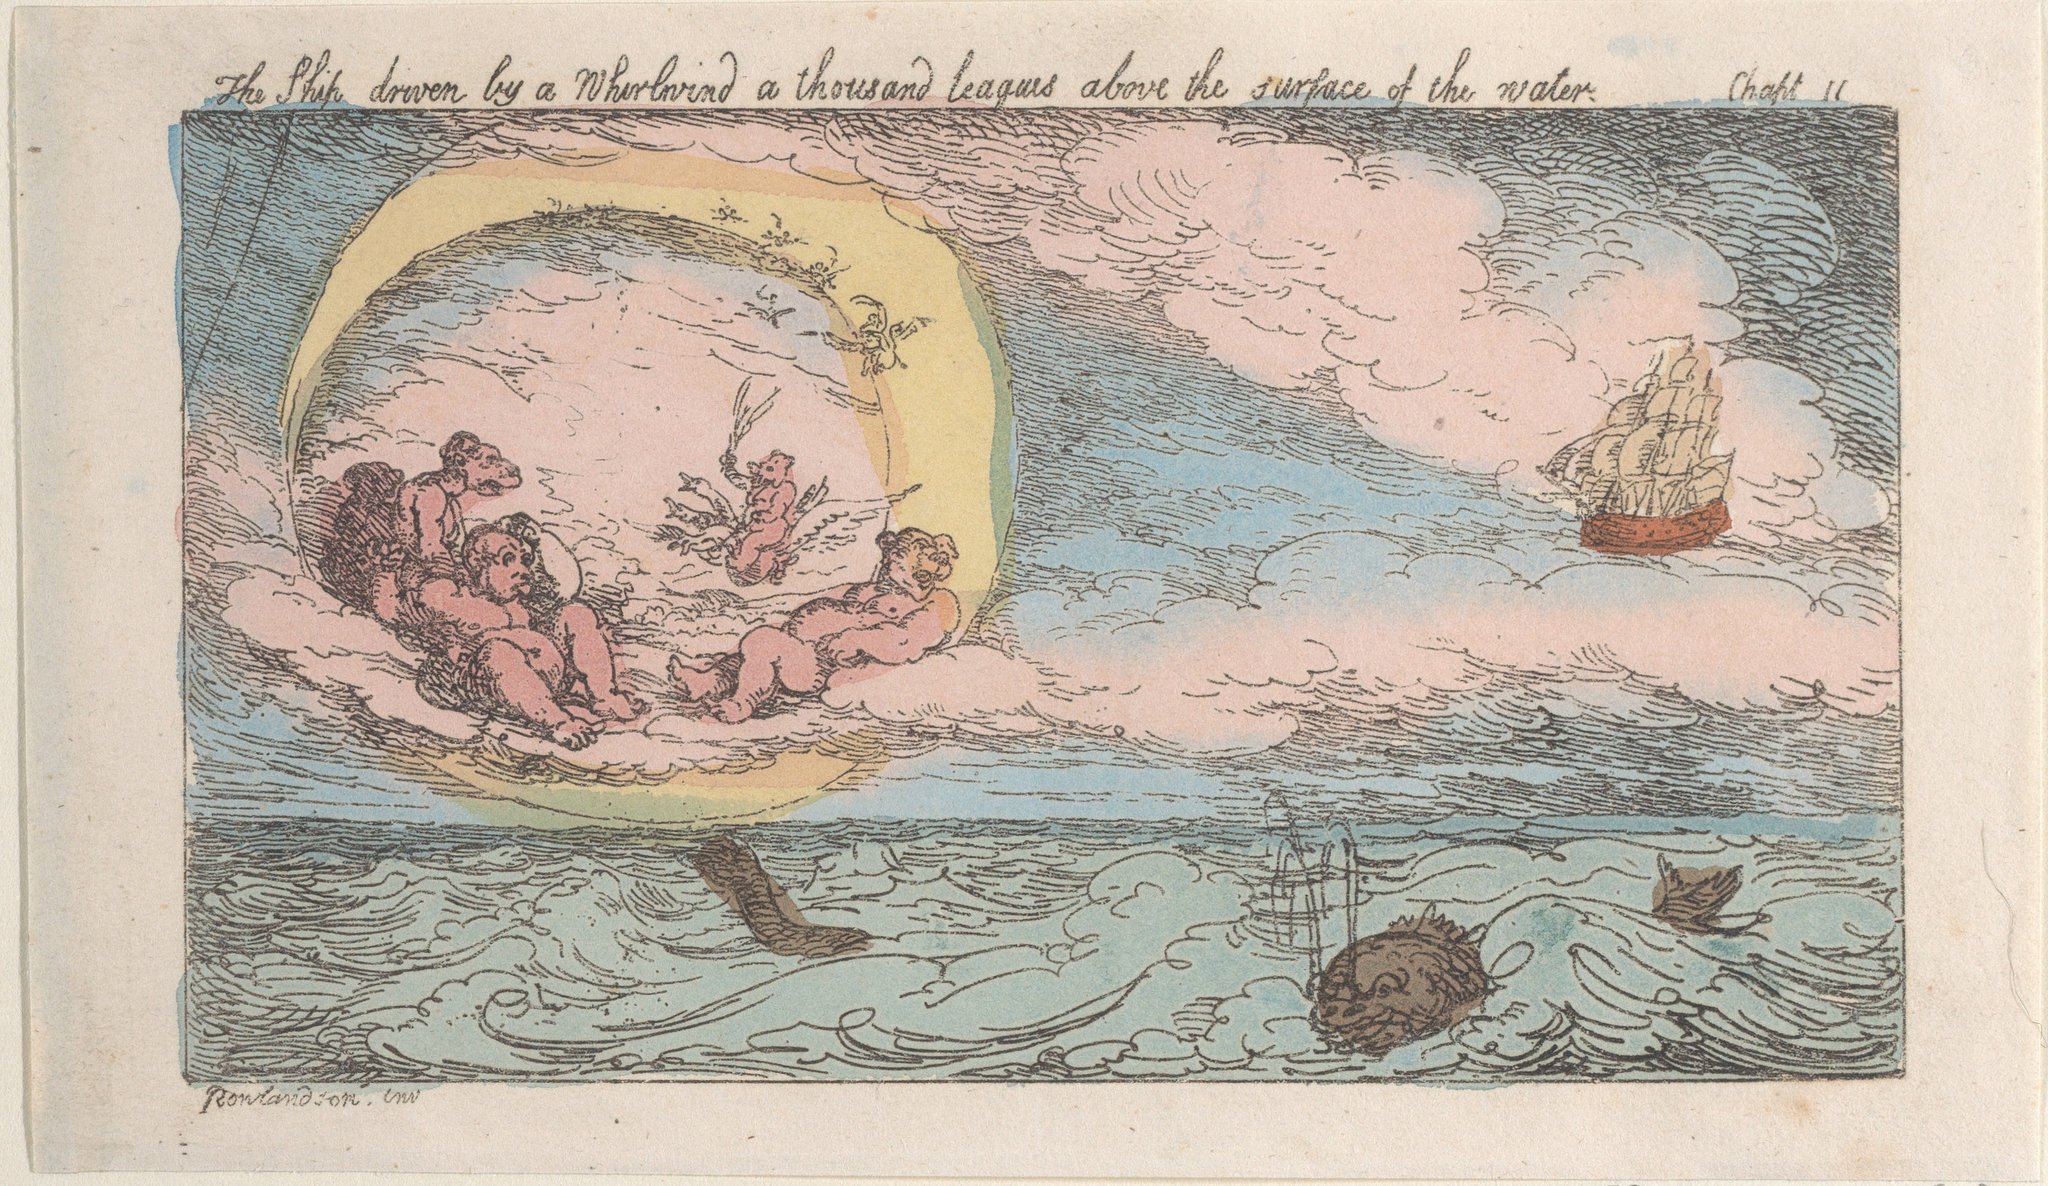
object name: print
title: The Ship, driven by a Whirlwind, a thousand leagues above the surface of the water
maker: thomas rowlandson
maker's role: artist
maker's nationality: british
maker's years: 1757-1827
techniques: etching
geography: london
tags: seas,ships